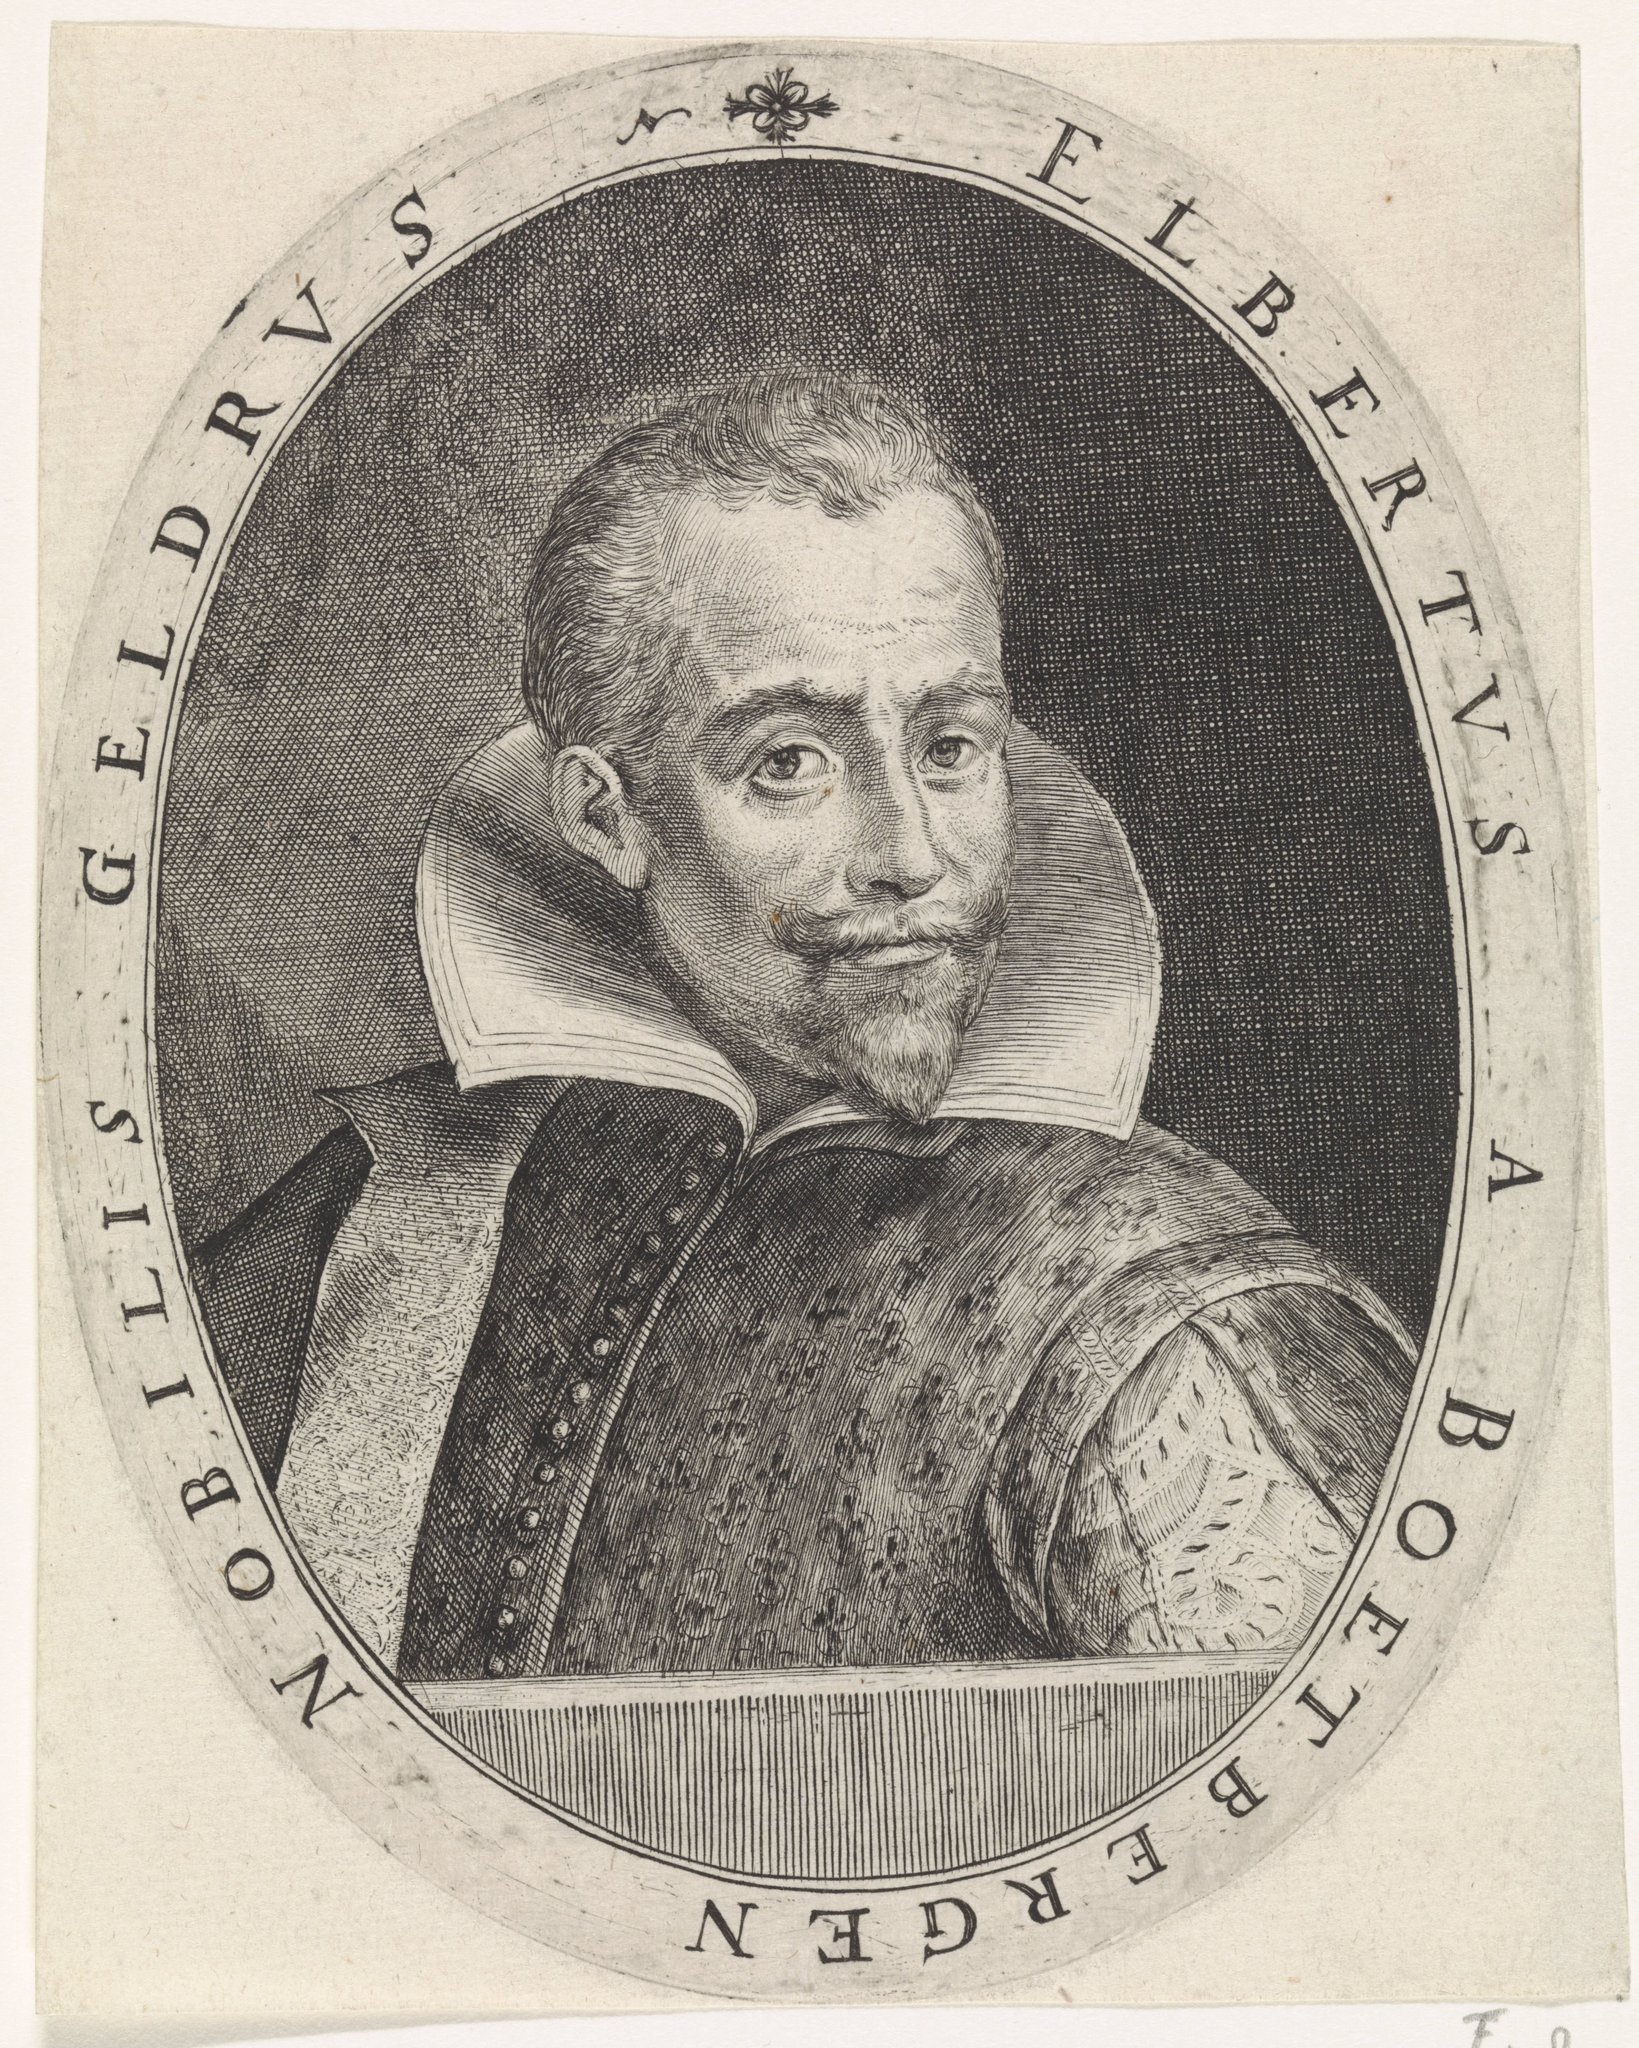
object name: print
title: Portret van Elbert van Boetbergen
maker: crispijn van de passe (i)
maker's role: draughtsman, print maker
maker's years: 1564-1637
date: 1574-1637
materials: paper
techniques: engraving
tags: elbert van boetbergen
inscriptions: collector's mark: Lugt 2228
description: Portret van Elbert van Boetbergen, Gelders edelman. In het randschrift van de omlijsting de naam en functie van de geportretteerde in het Latijn.